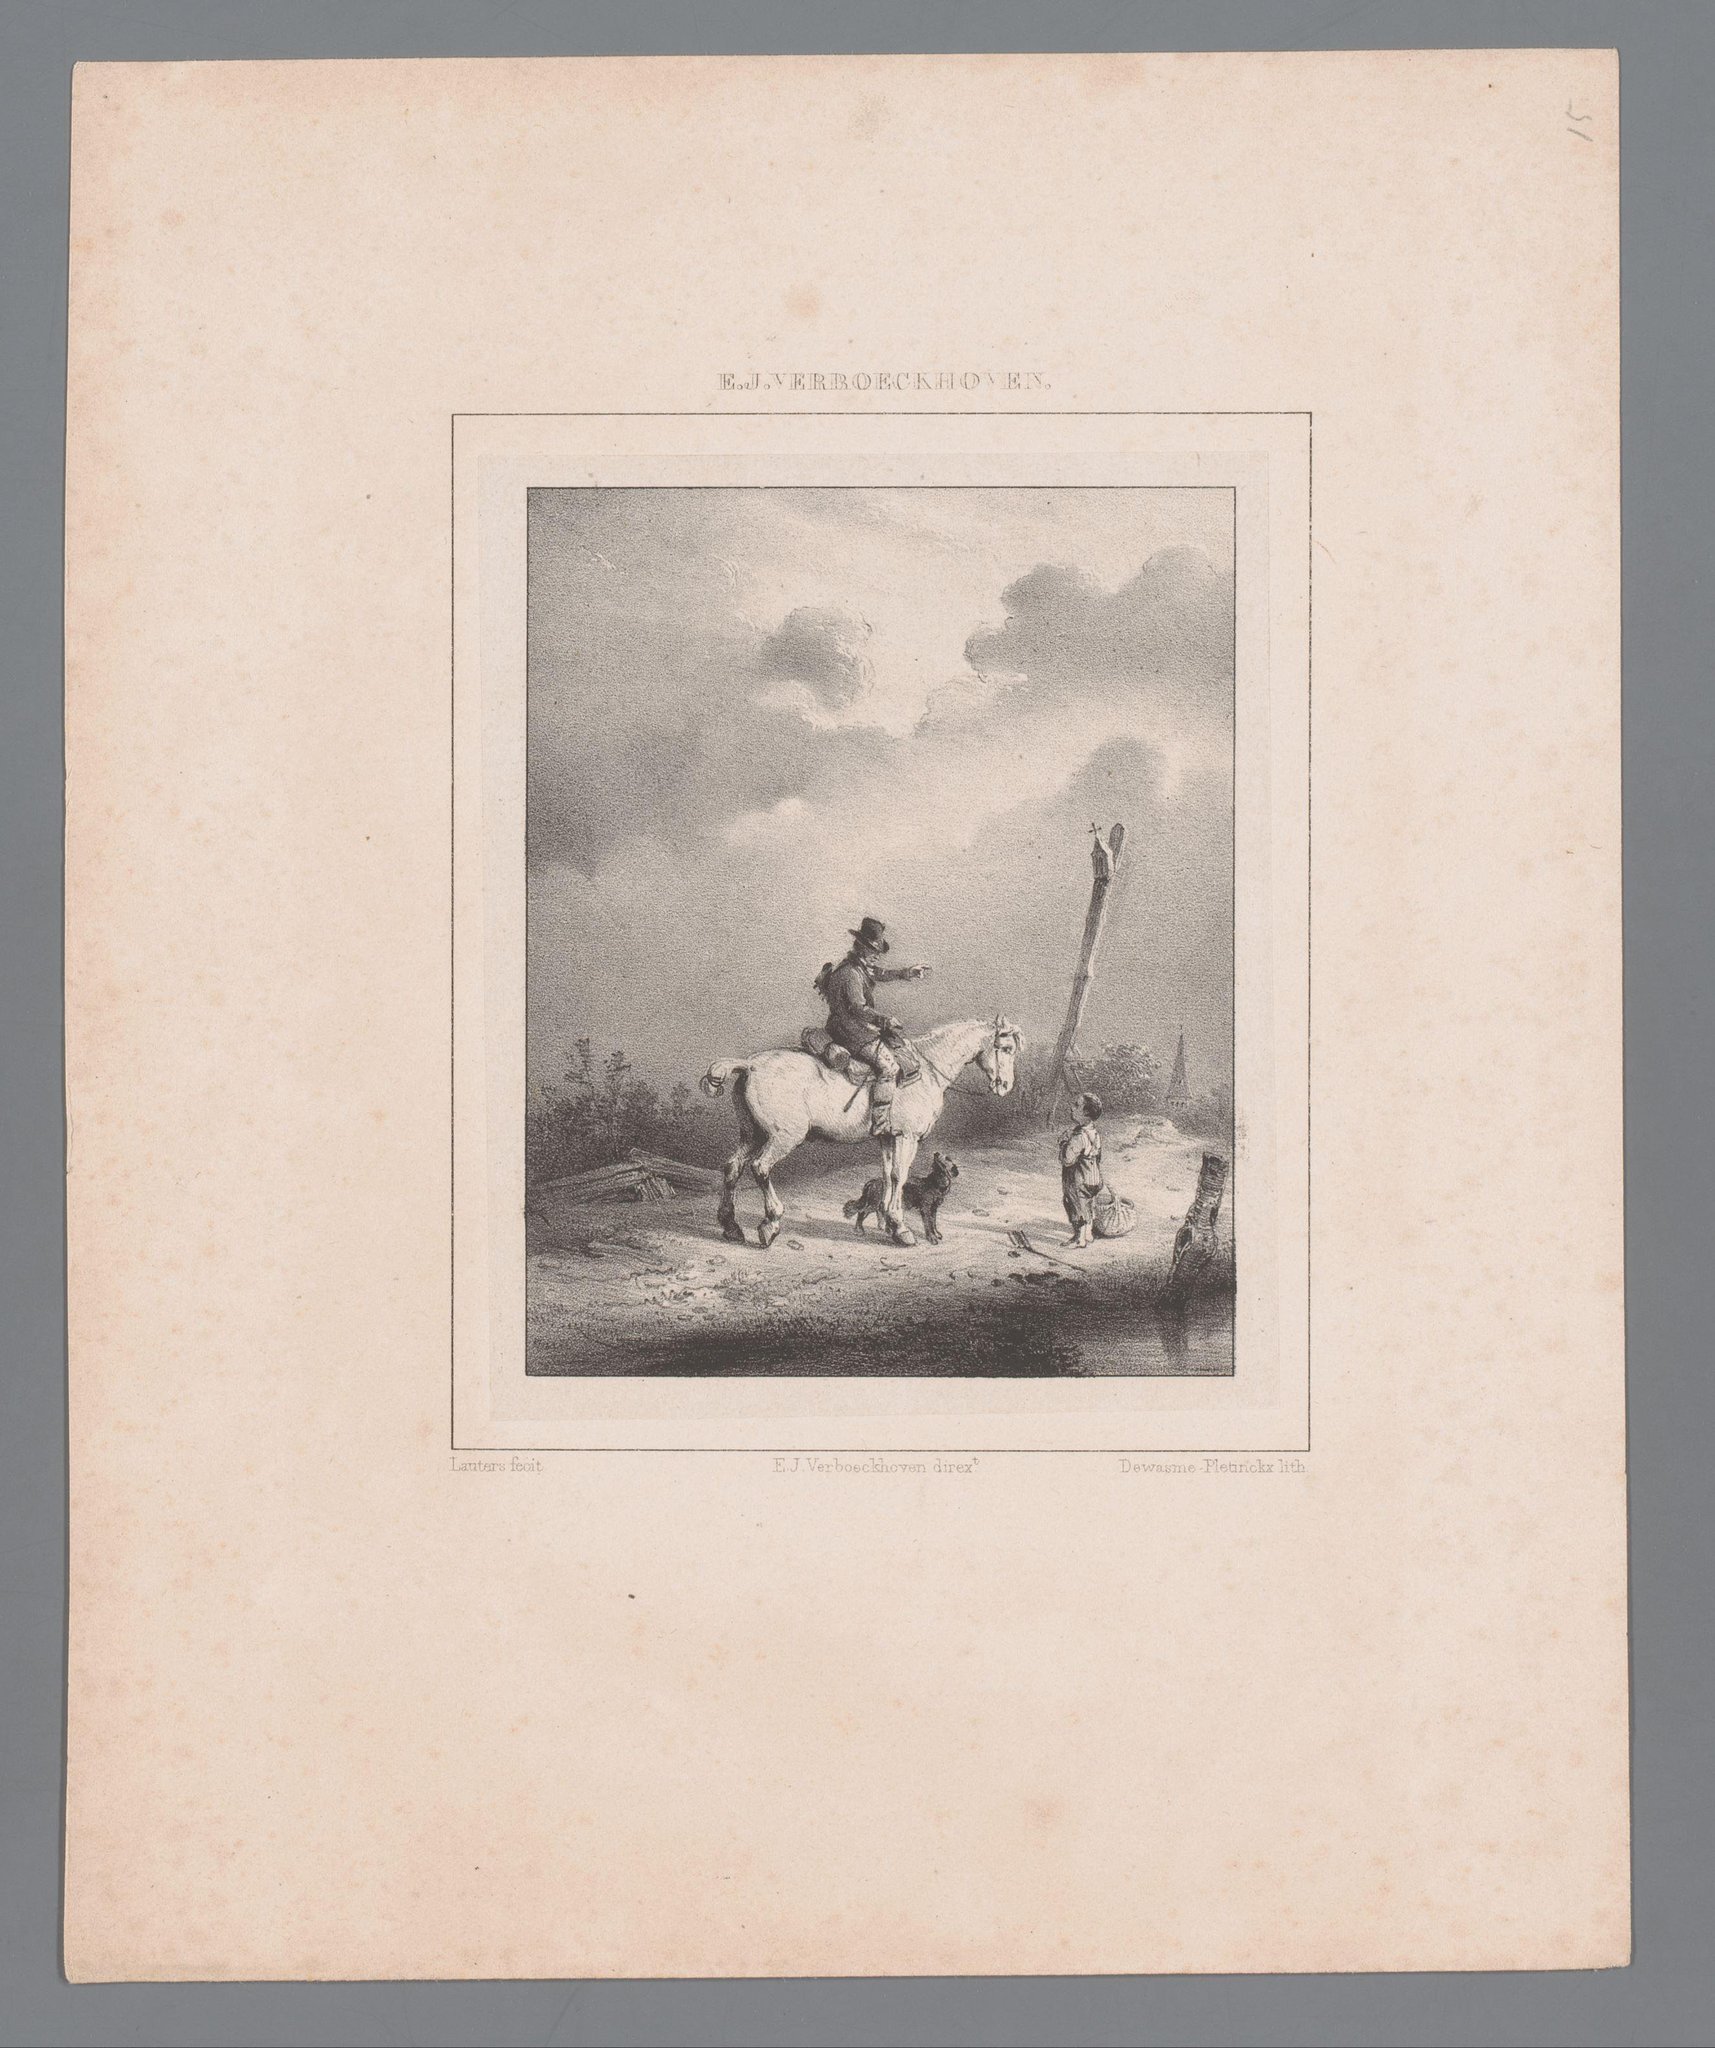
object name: print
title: Album lithographié par Paul Lauters d'après les dessins des principaux peintres du Royaume des Pays-Bas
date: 1829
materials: paper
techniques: lithograph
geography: brussels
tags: riding a horse, ass, or mule; rider, horseman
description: Prent verschenen in: Verboeckhoven, Eugène. Album lithographié par Paul Lauters d'après les dessins des principaux peintres du Royaume des Pays-Bas. Brussel: Antoine Dewasme-Pletinckx, 1829.